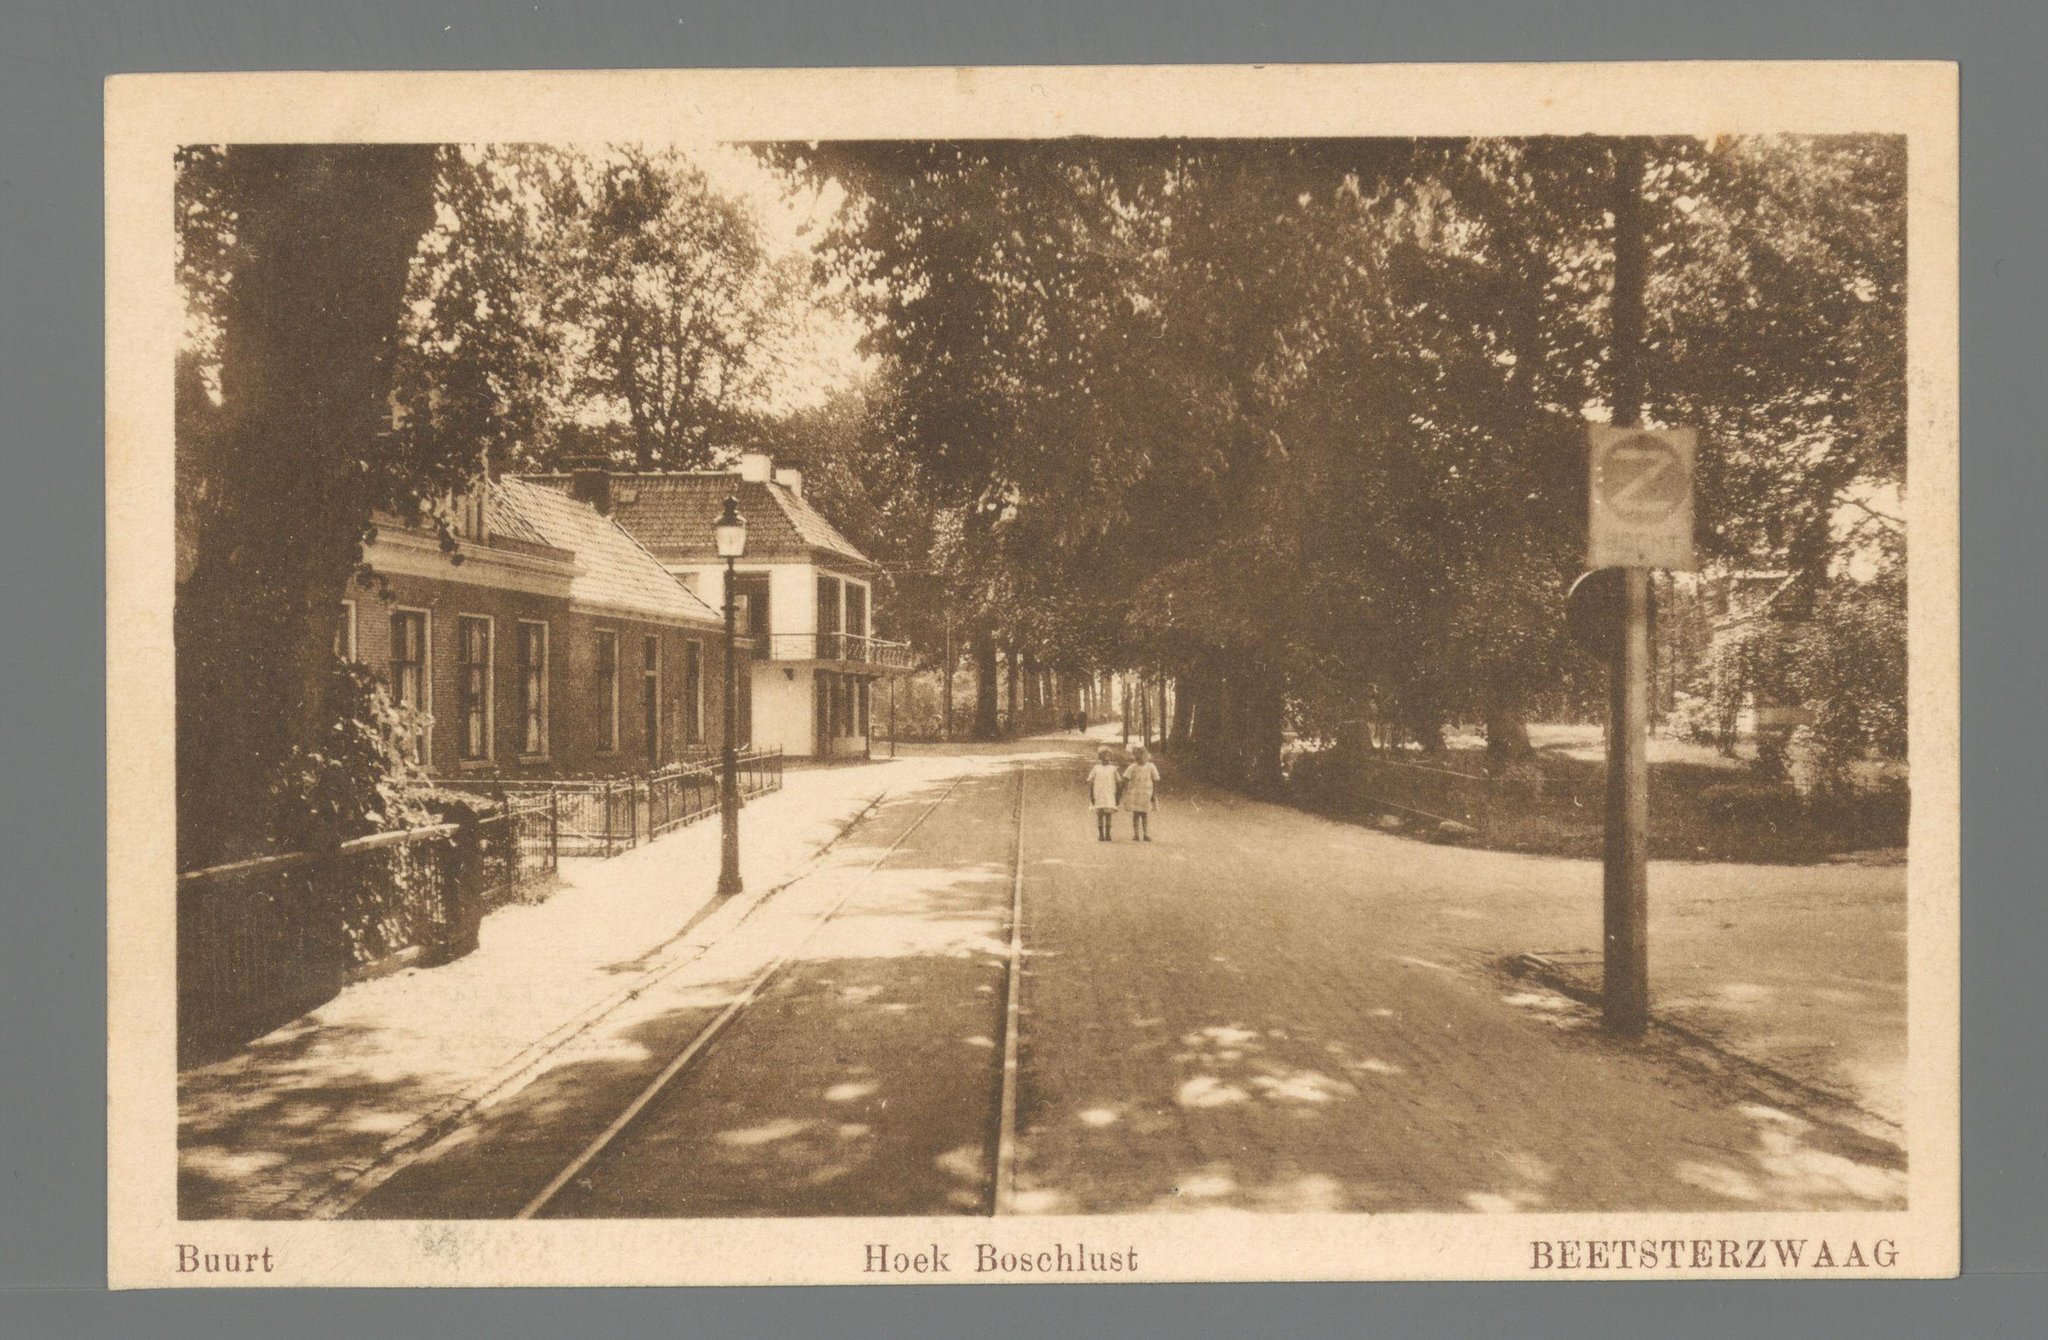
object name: photomechanical print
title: Buurt. Hoek Boschlust. Beetsterzwaag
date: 1913-1927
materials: cardboard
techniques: photograph, writing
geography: beetsterzwaag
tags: child, street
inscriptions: postage stamp